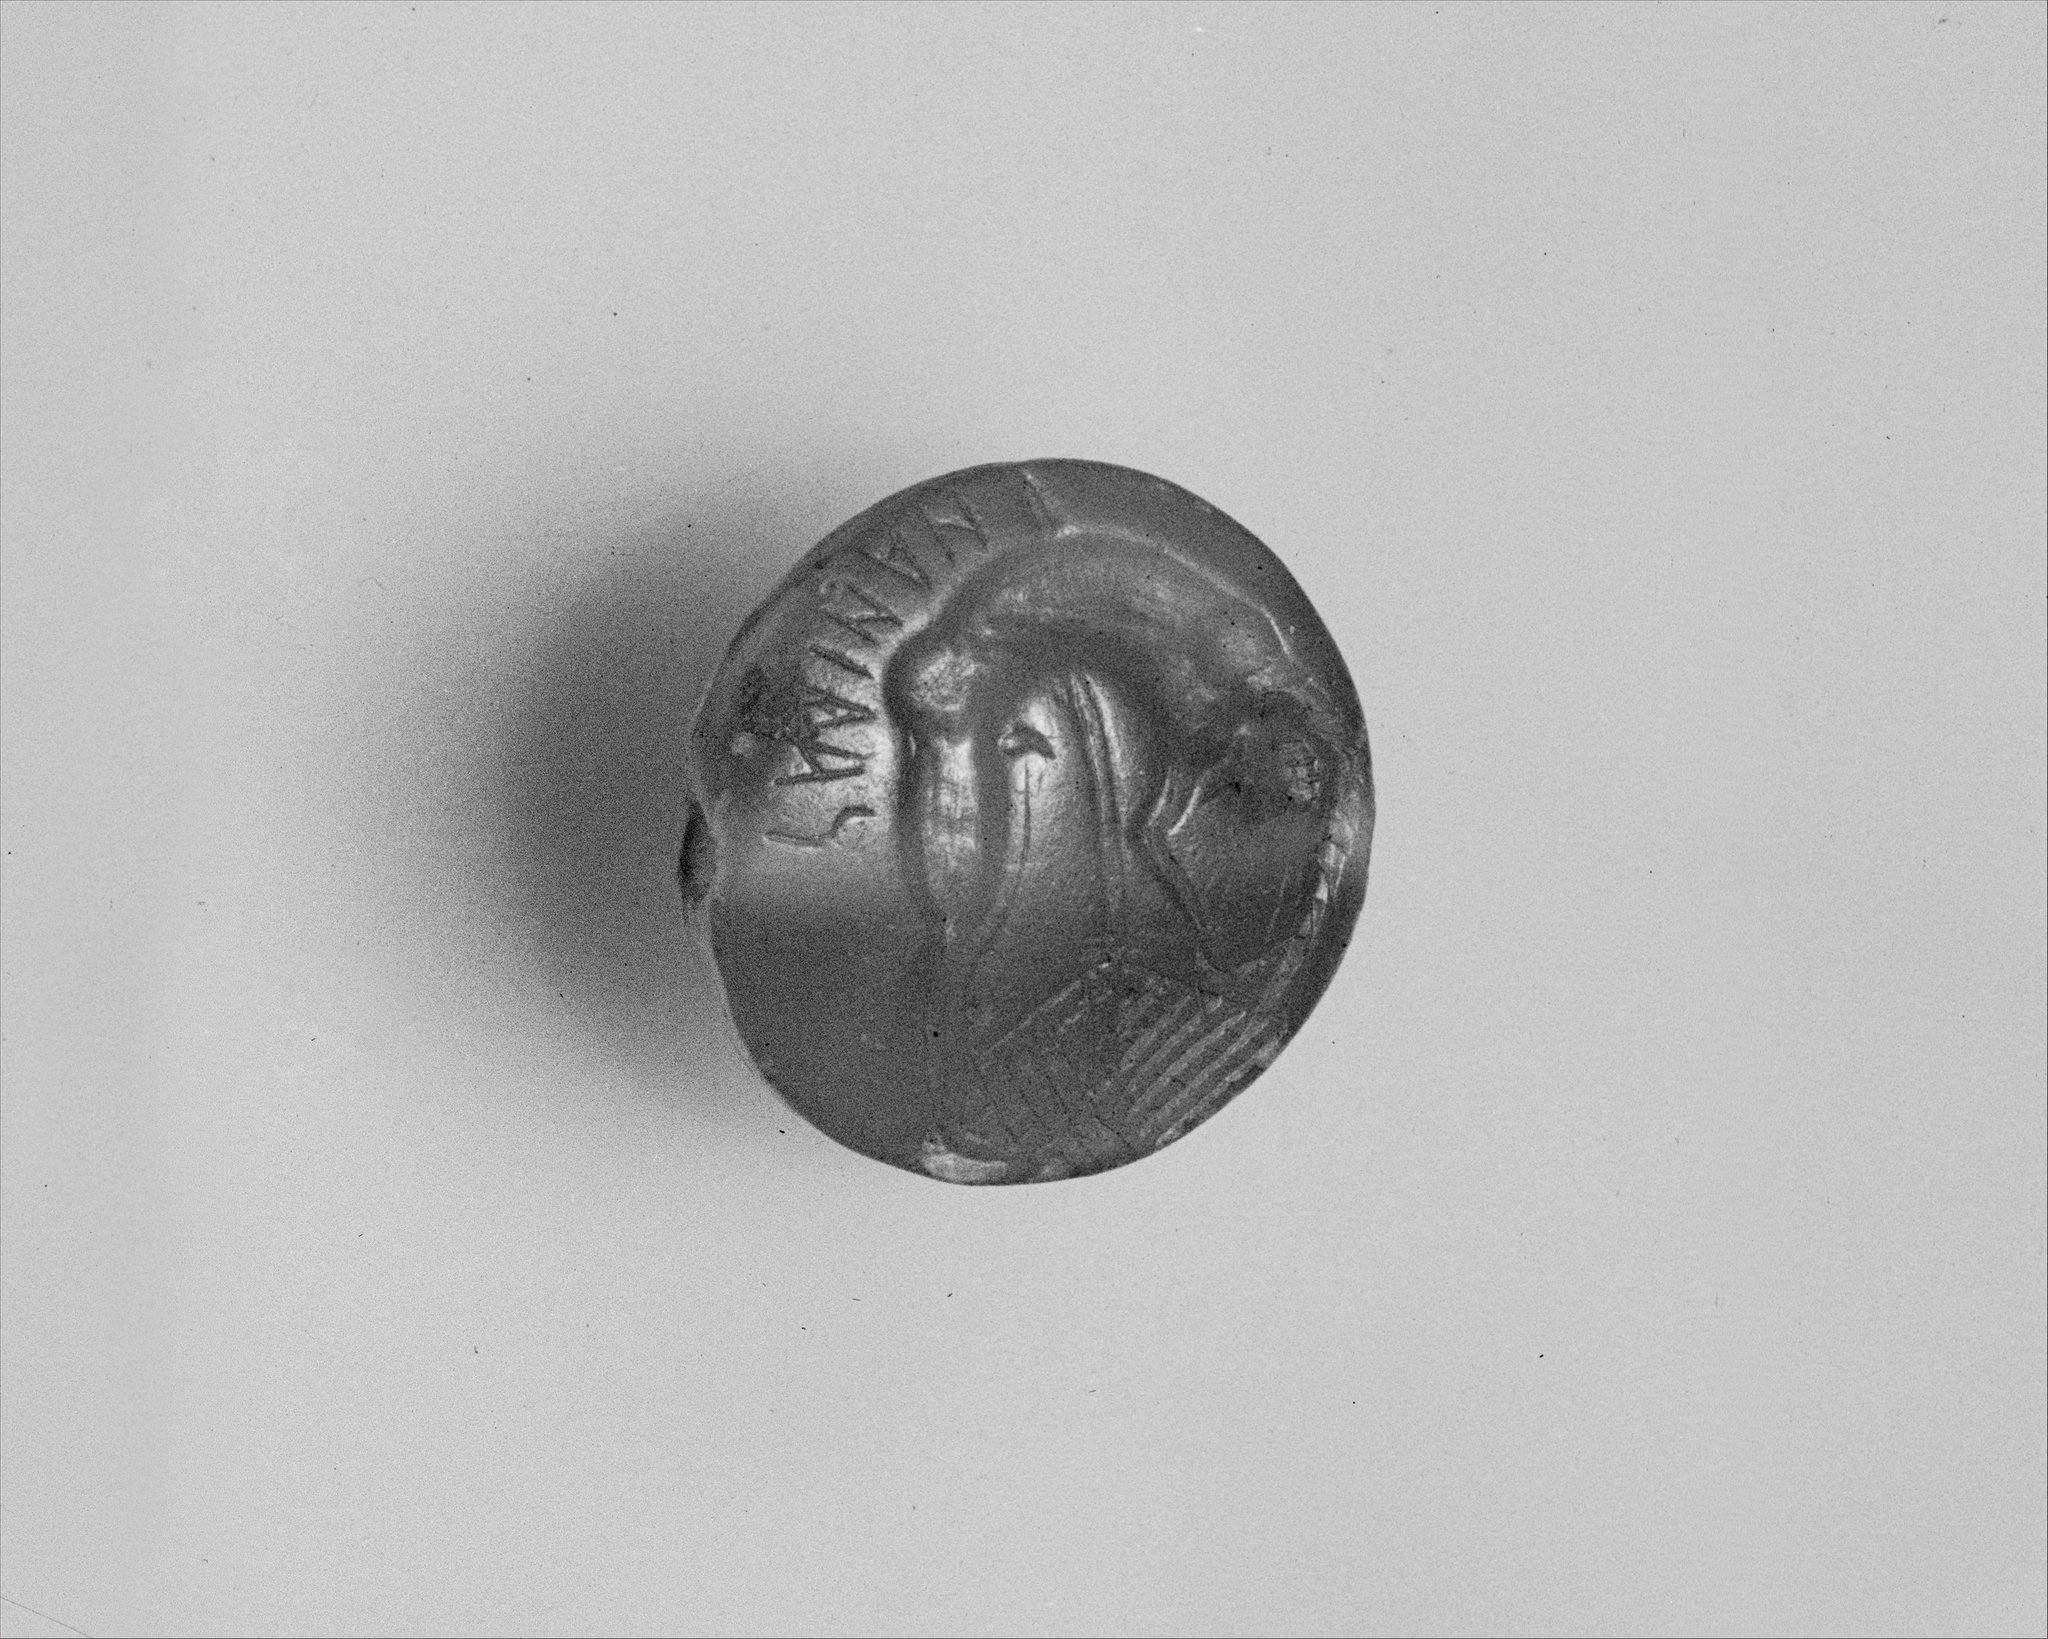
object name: intaglio, lentoid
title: Steatite engraved gem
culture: greek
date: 634-501 BCE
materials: stone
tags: swords,men,ajax